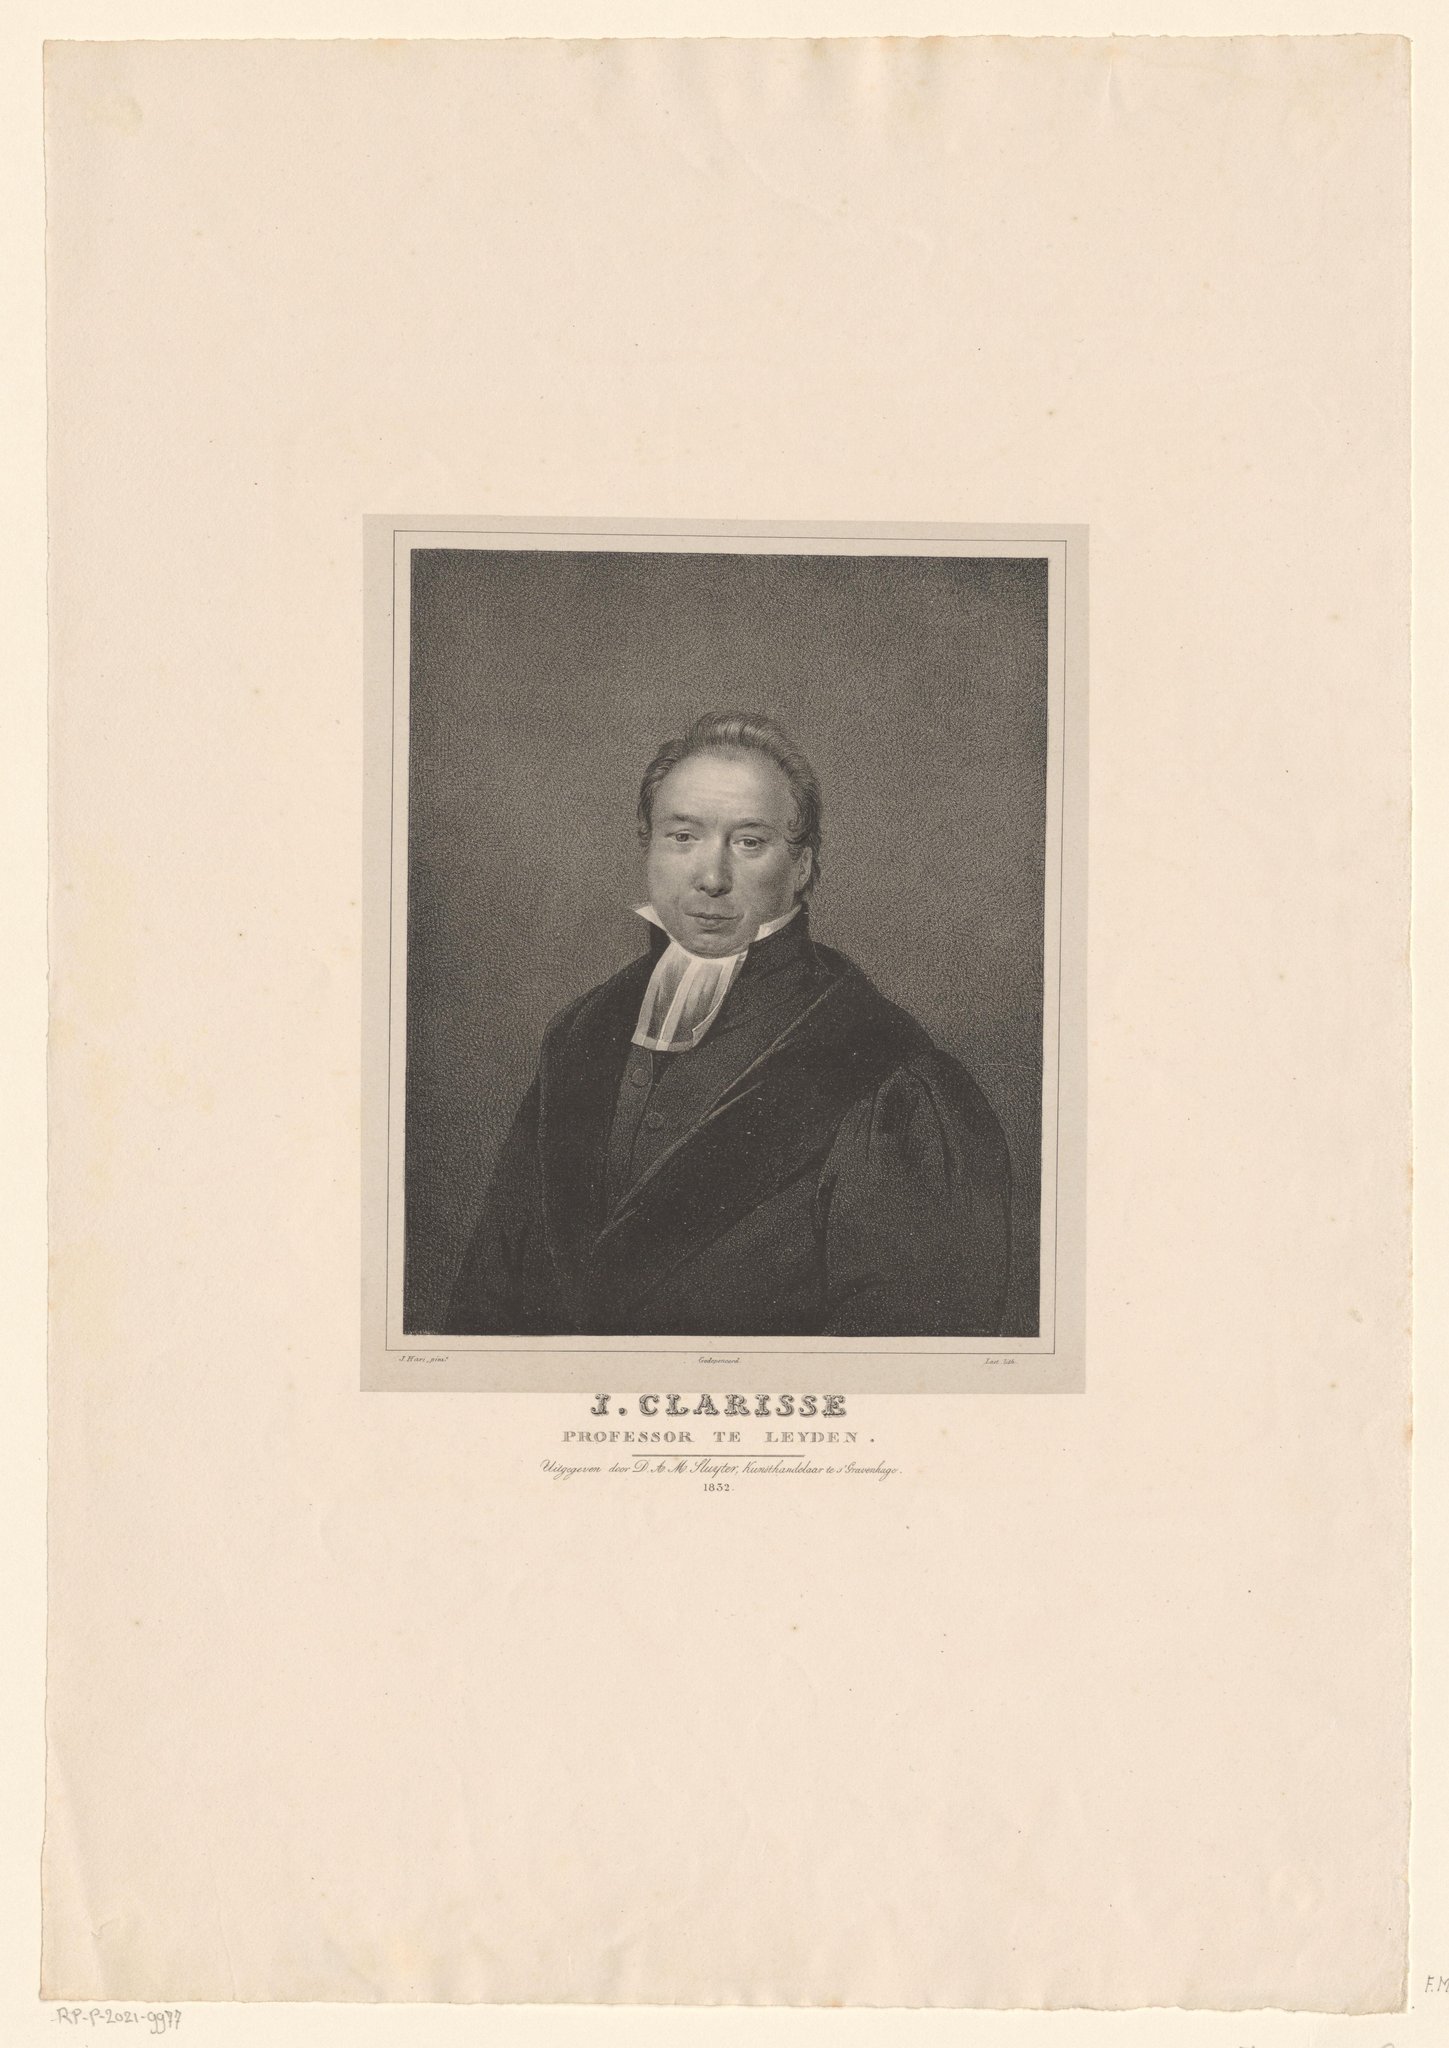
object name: print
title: Portret van Johannes Clarisse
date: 1832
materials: paper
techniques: lithograph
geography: the hague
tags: rhenen, historical persons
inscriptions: collector's mark: Lugt 2228, : ‘Gedeponeerd.’